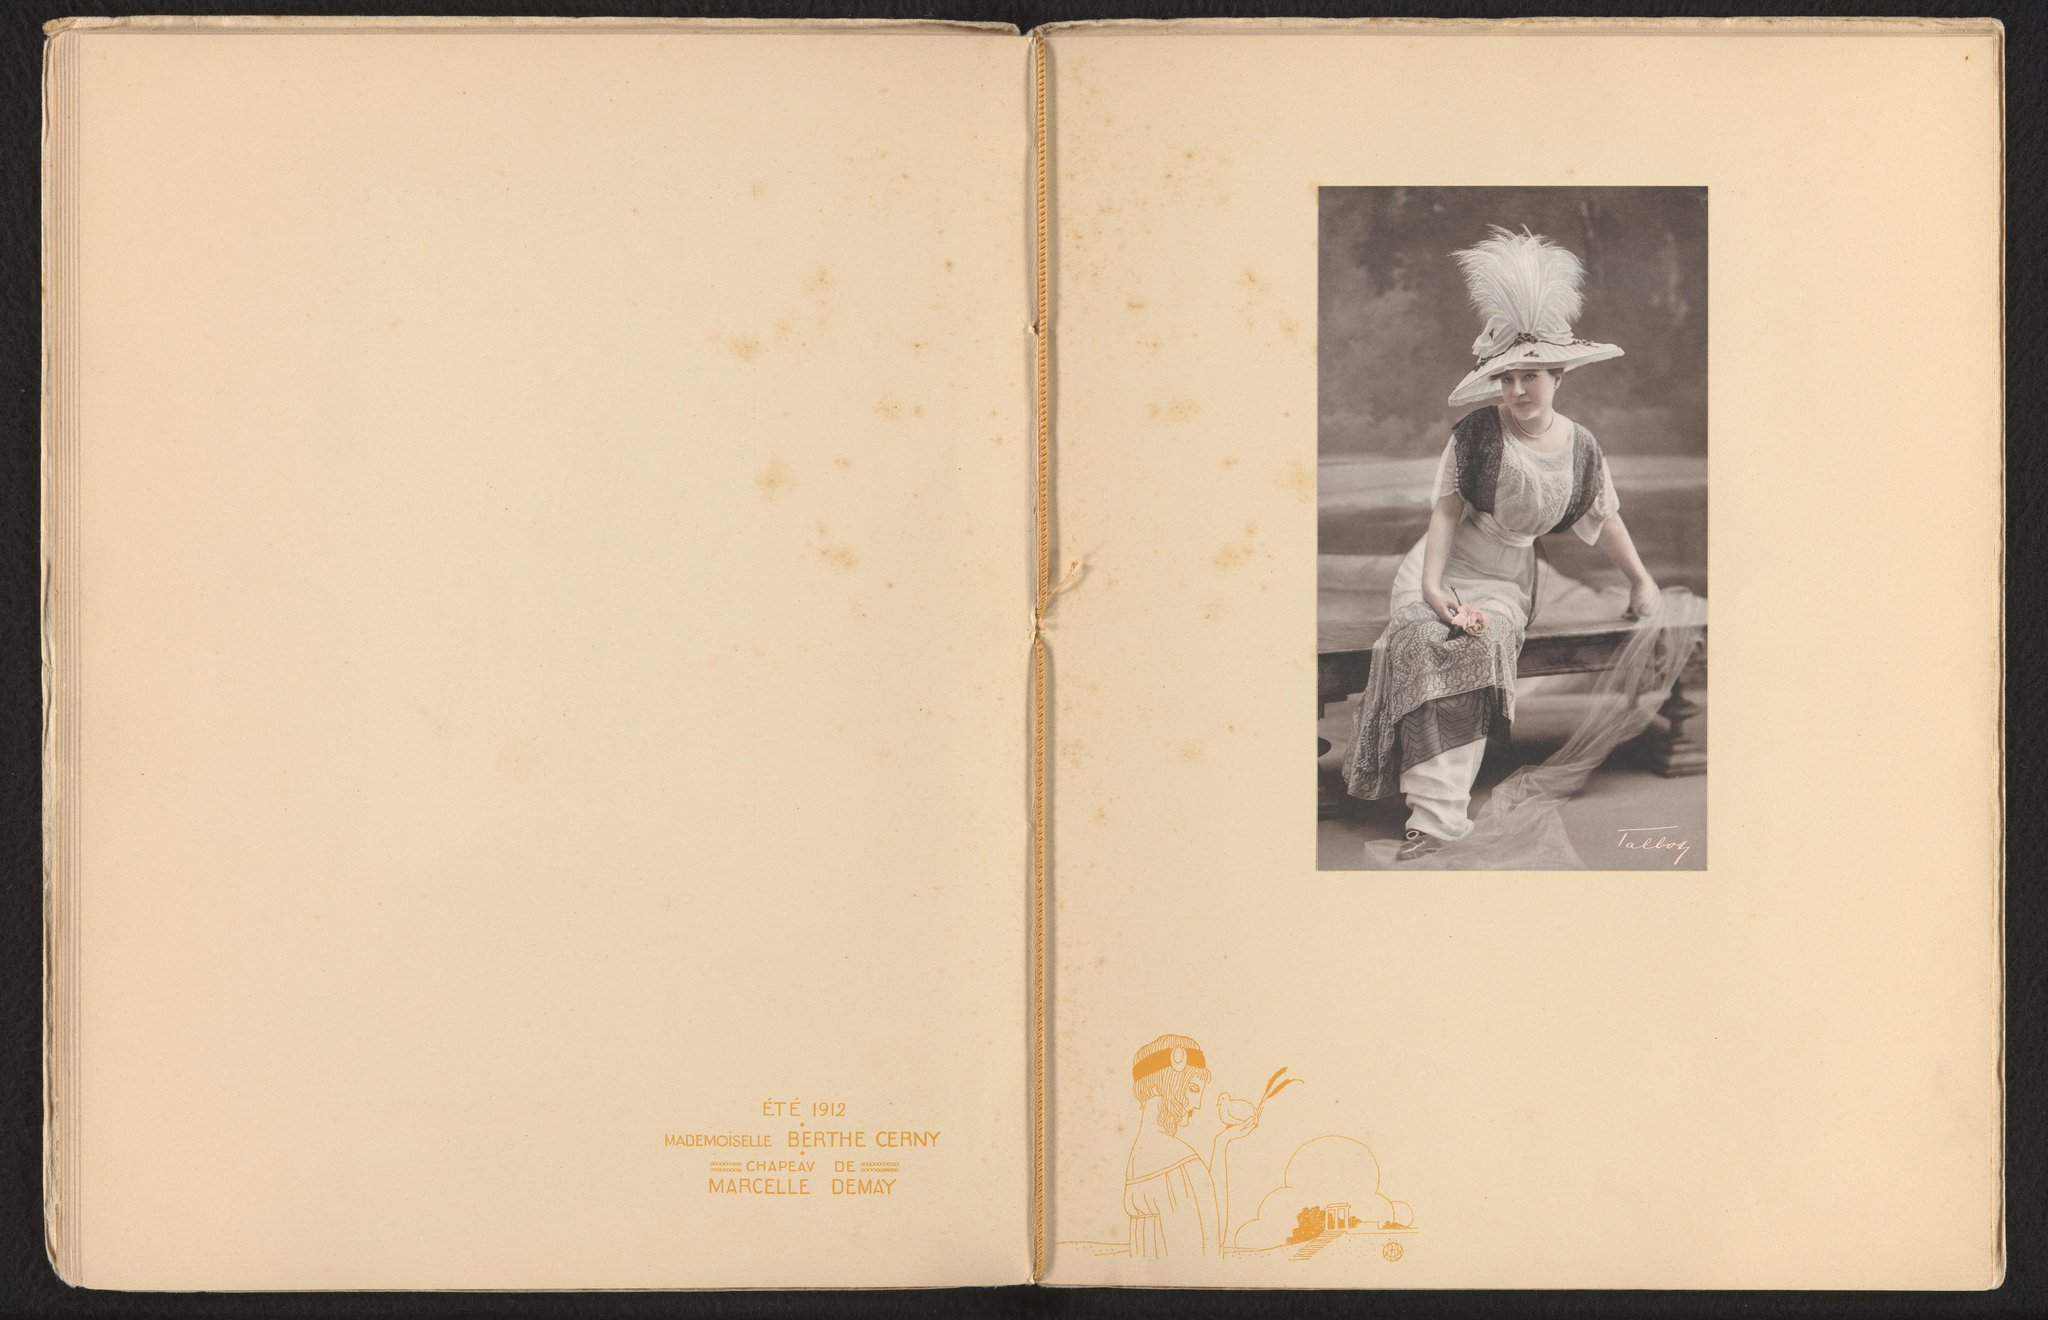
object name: photomechanical print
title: Portret van Berthe Cerny met hoed door Marcelle Demay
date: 1907-1912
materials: paper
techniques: two-color autotype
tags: paris, historical persons - bb - woman